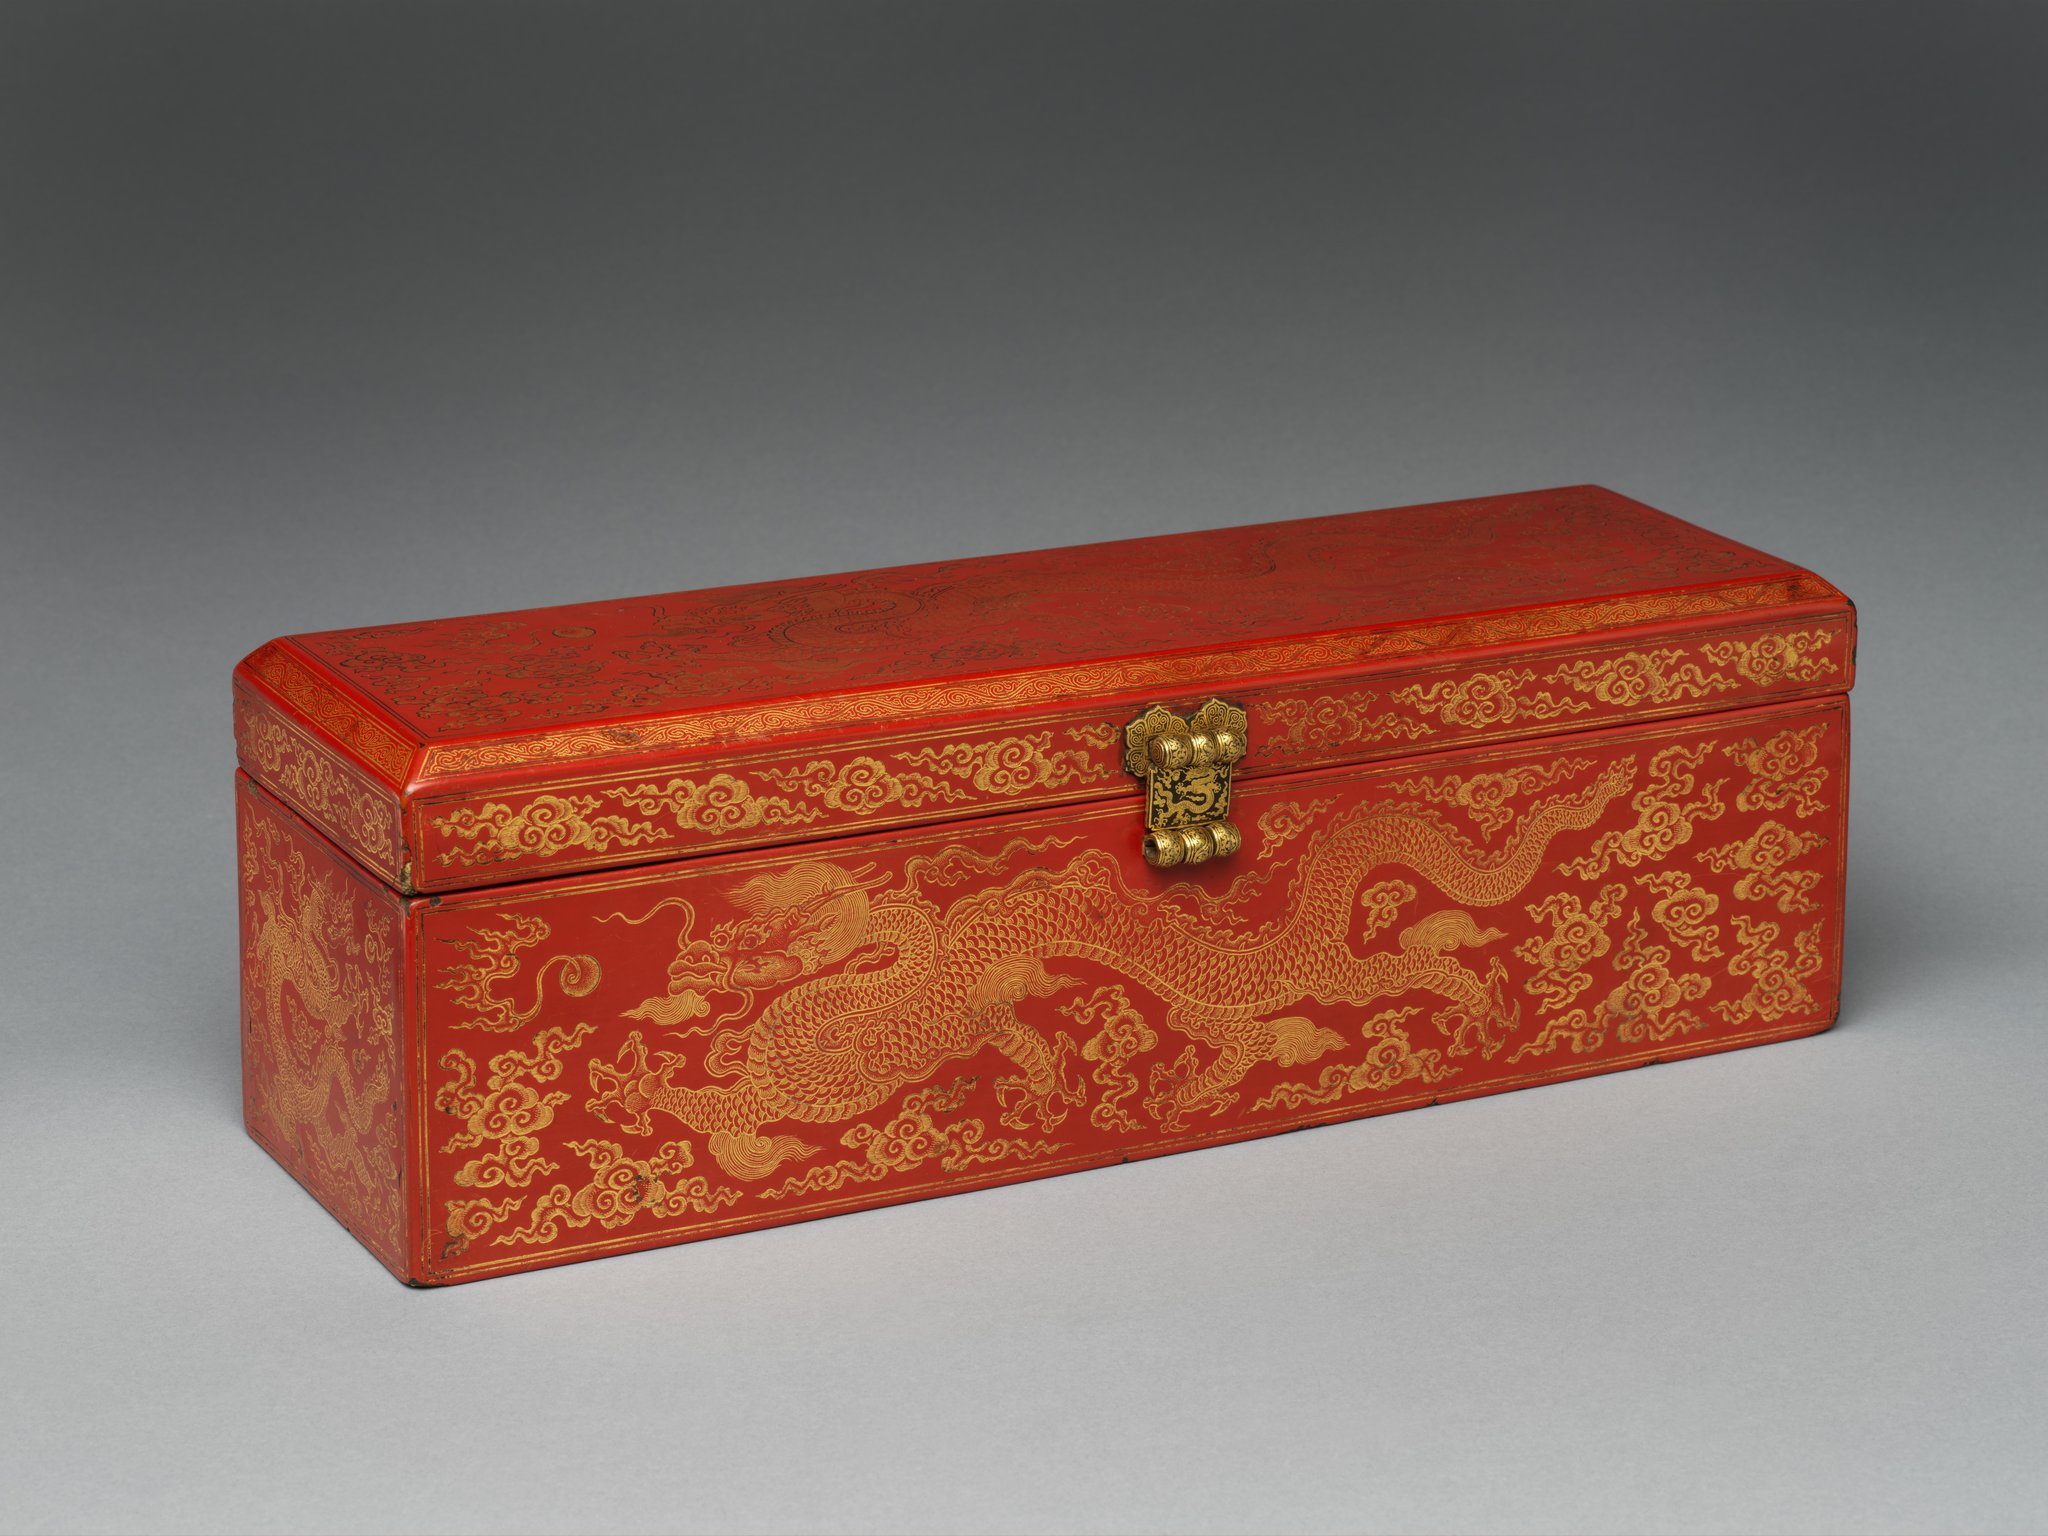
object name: sutra box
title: Sutra box with dragons amid clouds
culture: chinese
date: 1403-1424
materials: brass, gold, lacquer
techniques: incising, inlay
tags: dragons